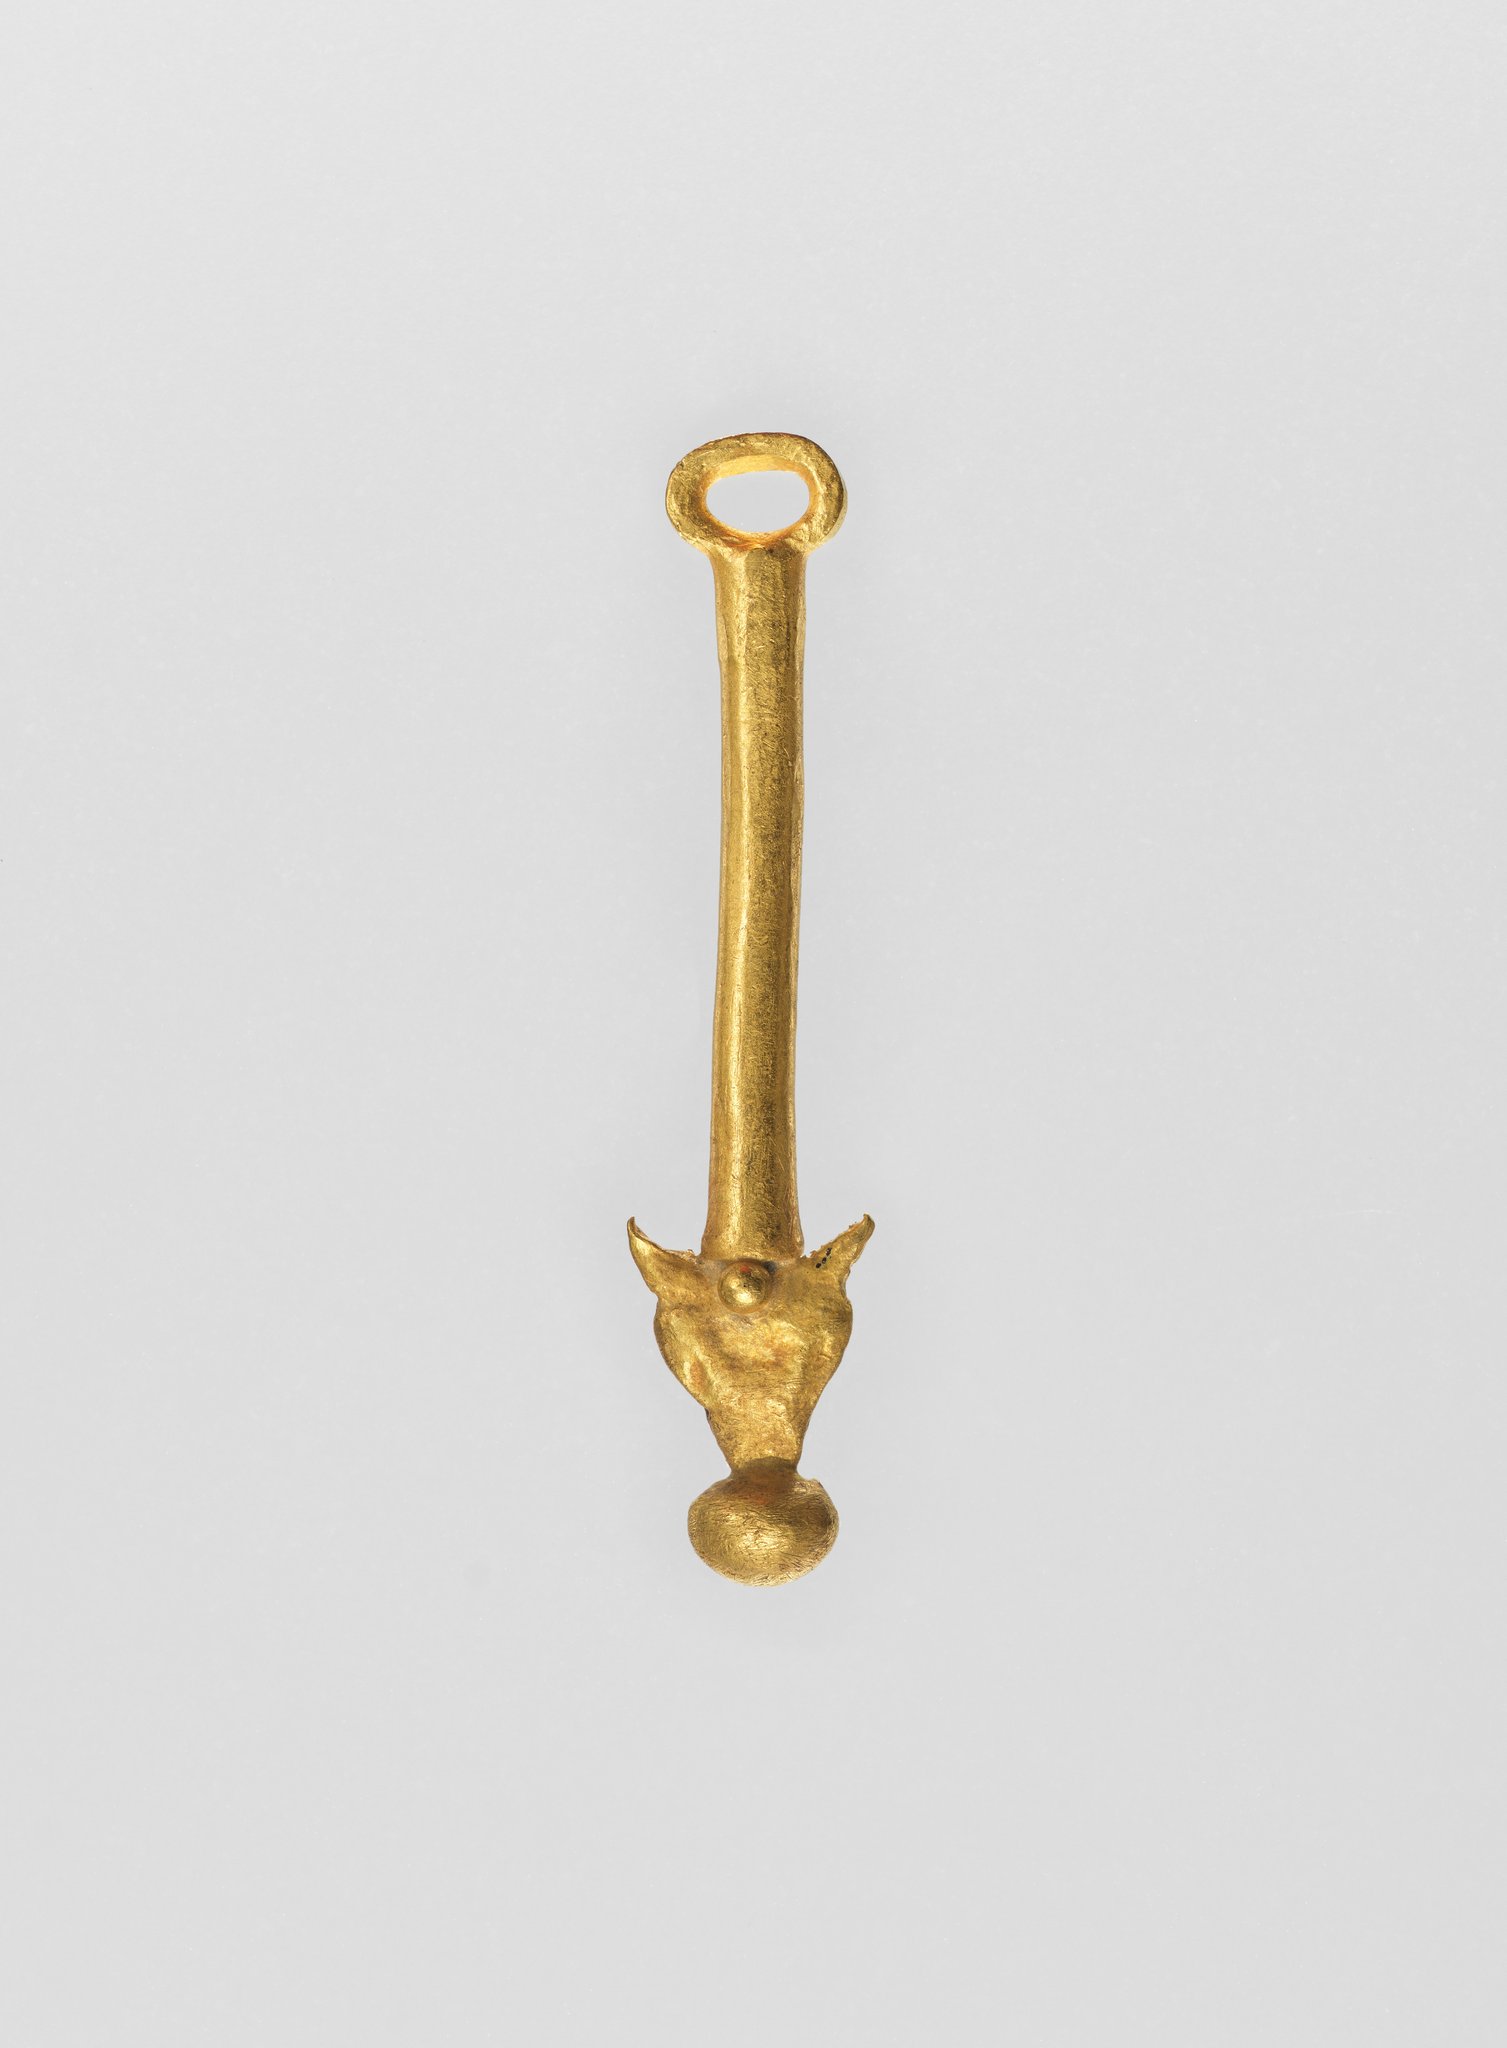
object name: amulet pendant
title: Pendant amulet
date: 332-330 BCE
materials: gold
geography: egypt